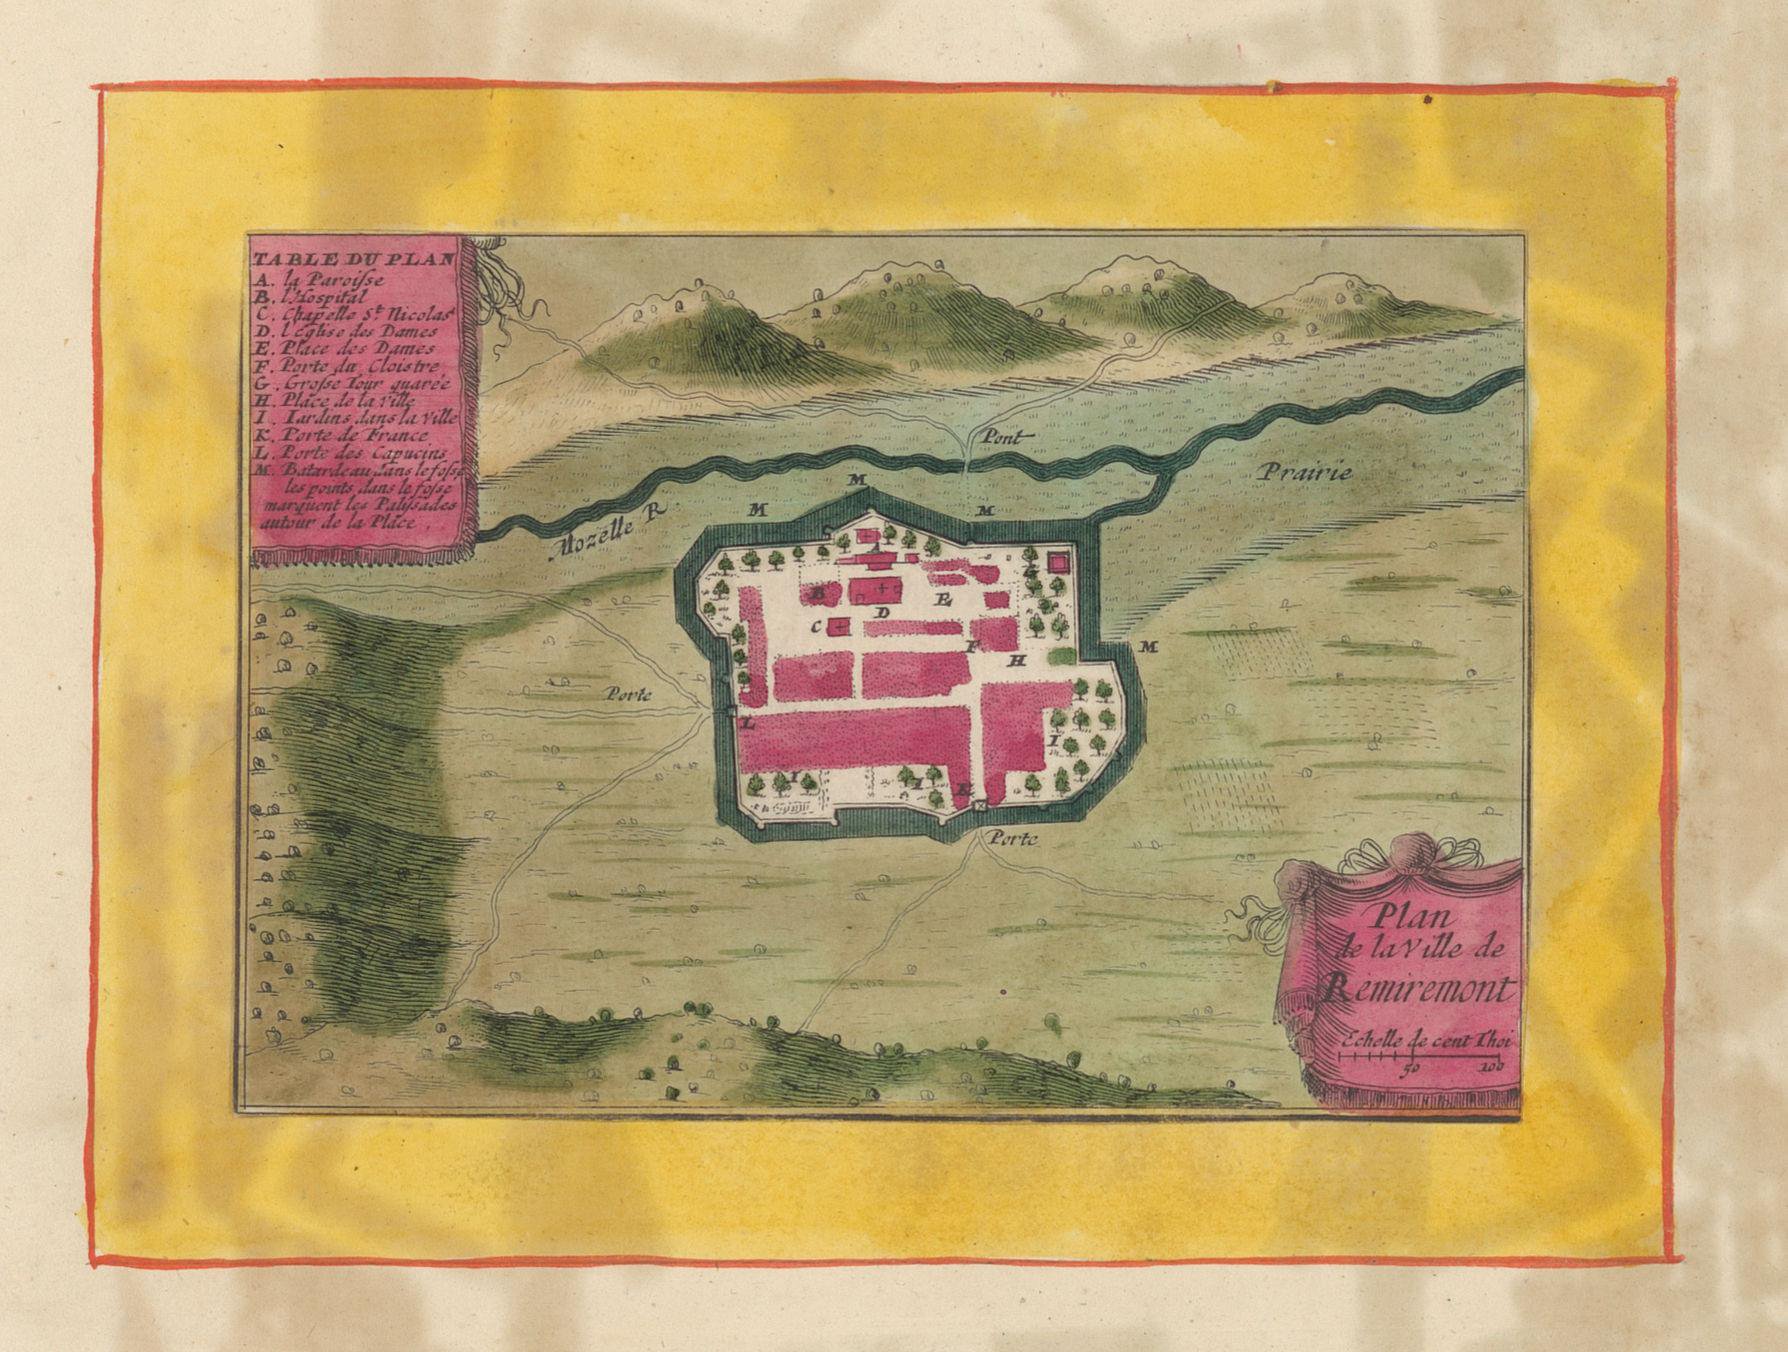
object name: print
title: Plan de la ville de Remiremont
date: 1700-1702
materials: paper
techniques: engraving, hand coloring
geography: the hague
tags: maps of cities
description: Deze plattegrond is in meerdere atlassen gebruikt. Onder andere in: Les forces de l'Europe. 10 dln. Amsterdam: Pieter Mortier, ca. 1700. En in: Les forces de l'Europe. 12 dln. Amsterdam: Pieter Mortier, 1702. Door het ontbreken van de marges van deze prent is onduidelijk om welke staat het gaat. Derhalve is niet te bepalen uit welke van deze publicaties dit exemplaar komt. Later is deze zelfde prent door Pieter van der Aa gebruikt in twee publicaties. Gezien het eind van de werkzame periode van de inkleurder van de prenten in dit album is het niet mogelijk dat deze prent uit een van die publicaties komt.